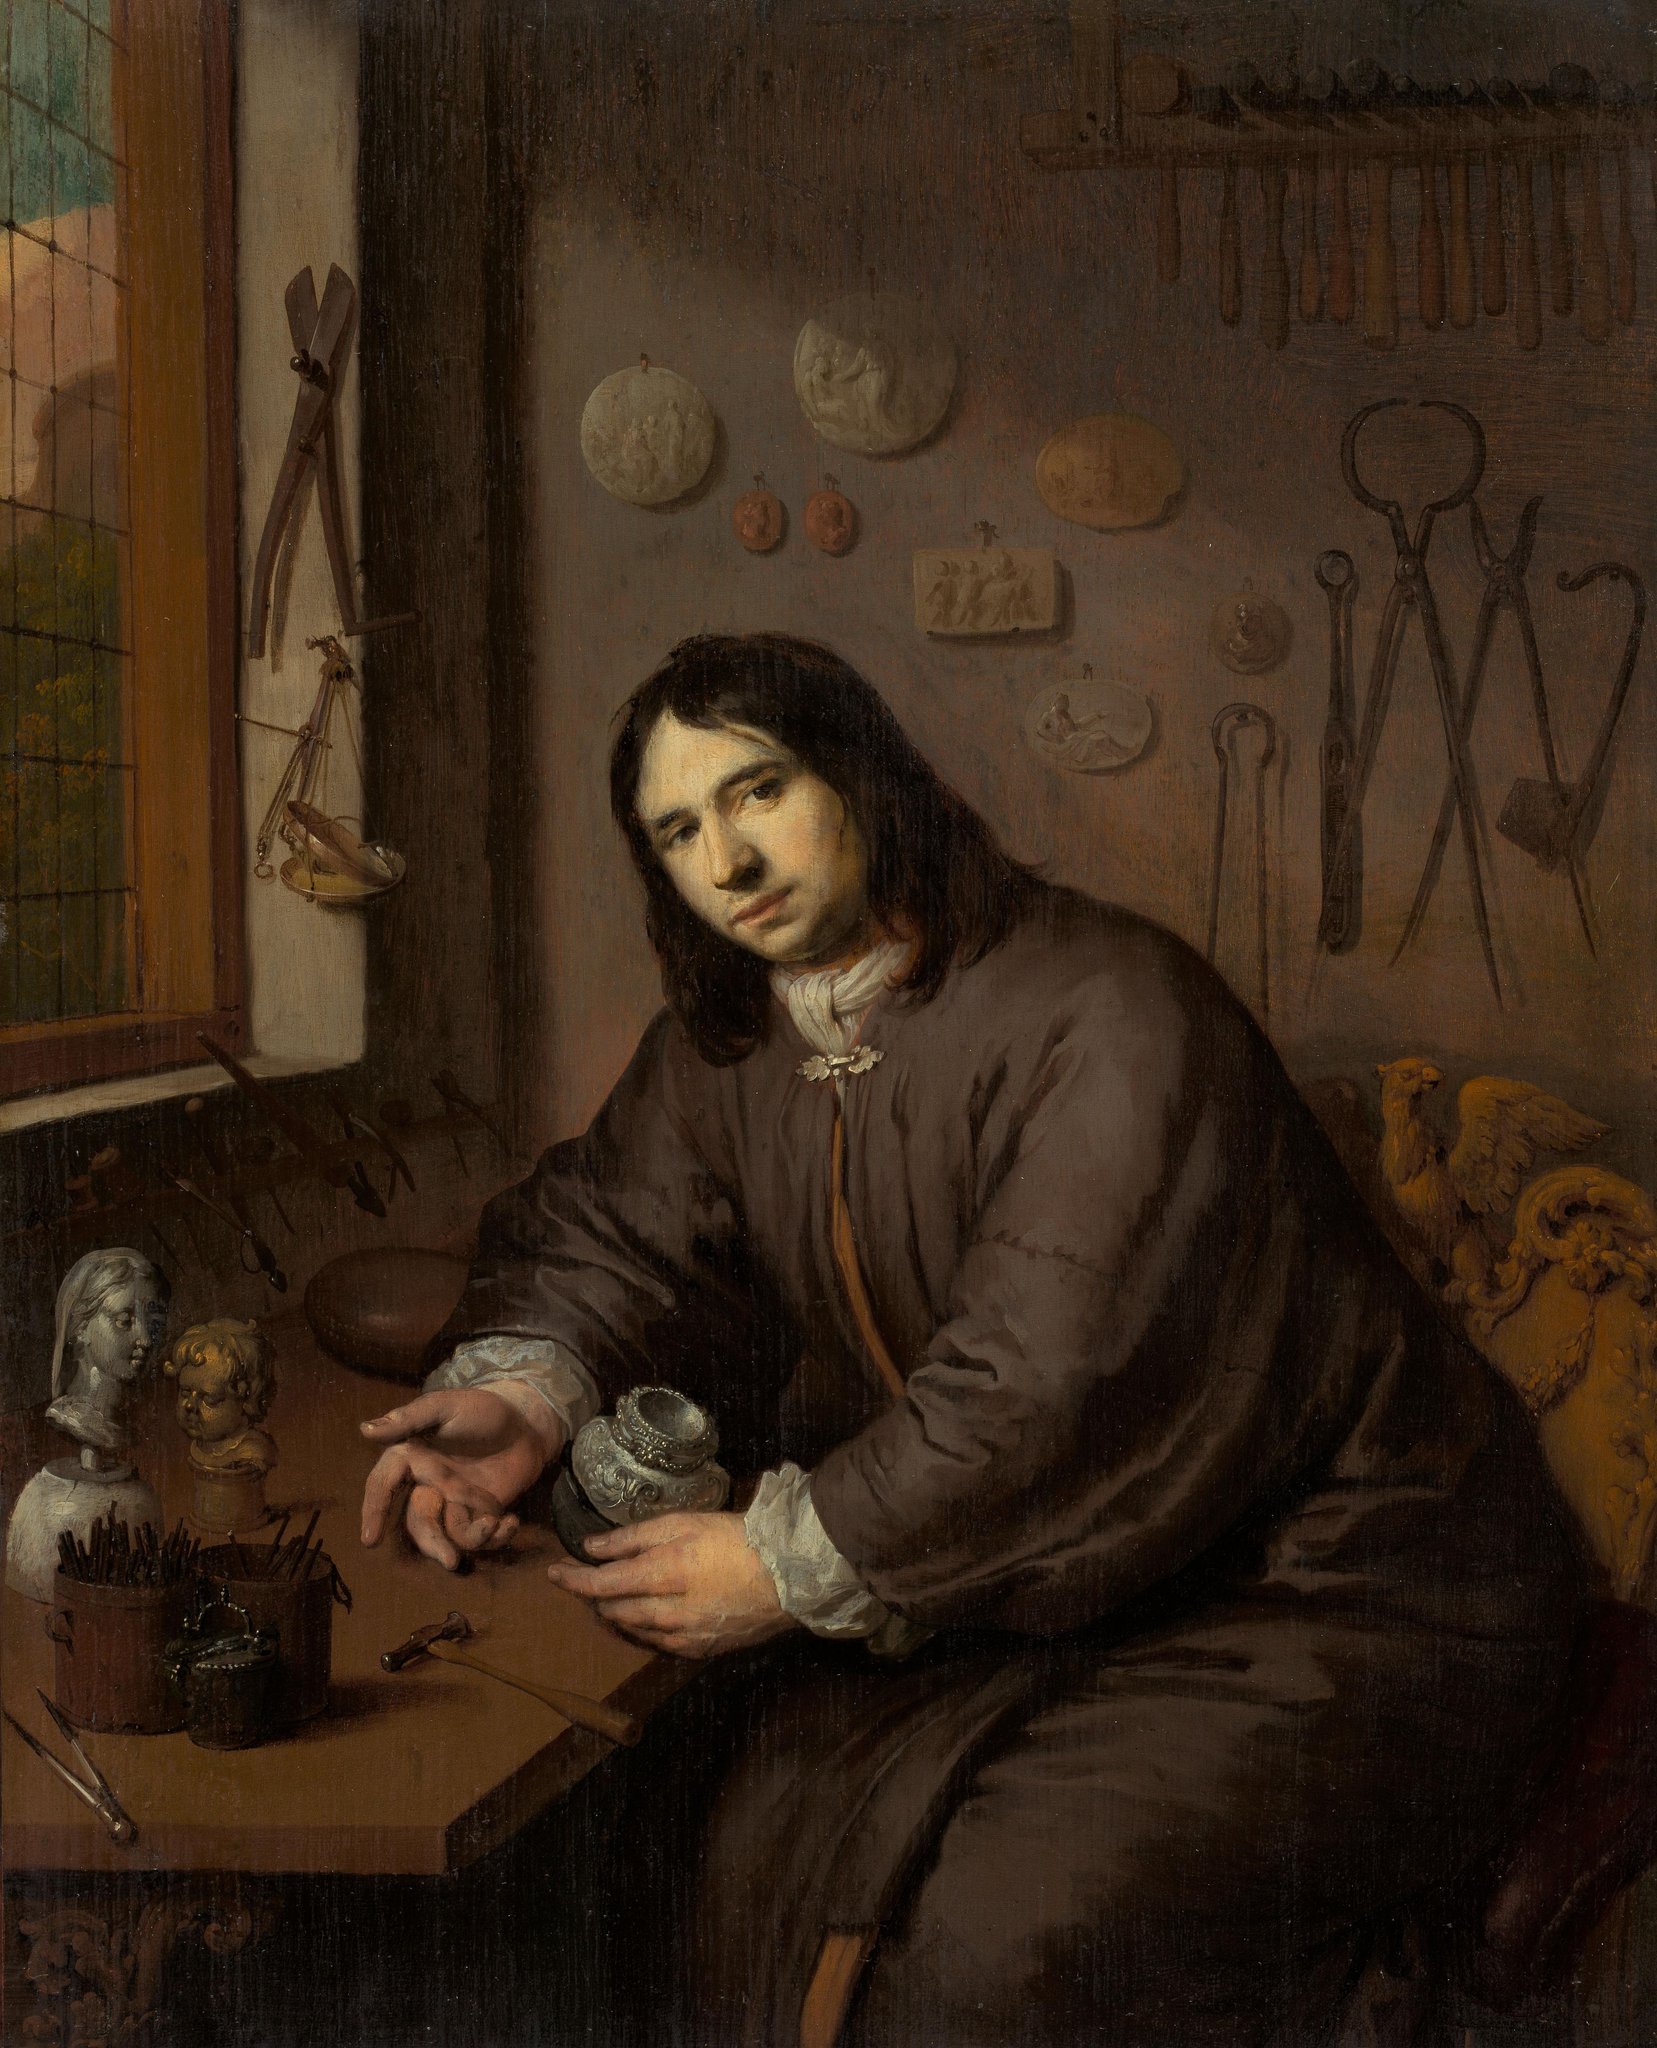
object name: painting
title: Portrait of a Goldsmith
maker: Anonymous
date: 1680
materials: oil, panel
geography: northern netherlands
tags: jeweller, goldsmith, silversmith (+ in workshop or studio), anonymous historical person portrayed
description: Portret van een edelsmid, zittend in zijn werkplaats aan een werktafel, in de handen een zilveren kannetje. Op tafel ligt een drijfhamer, ander gereedschap en twee kinderkopjes. Aan de wand een weegschaal, plaquetten, tangen, hamers en andere werktuigen.